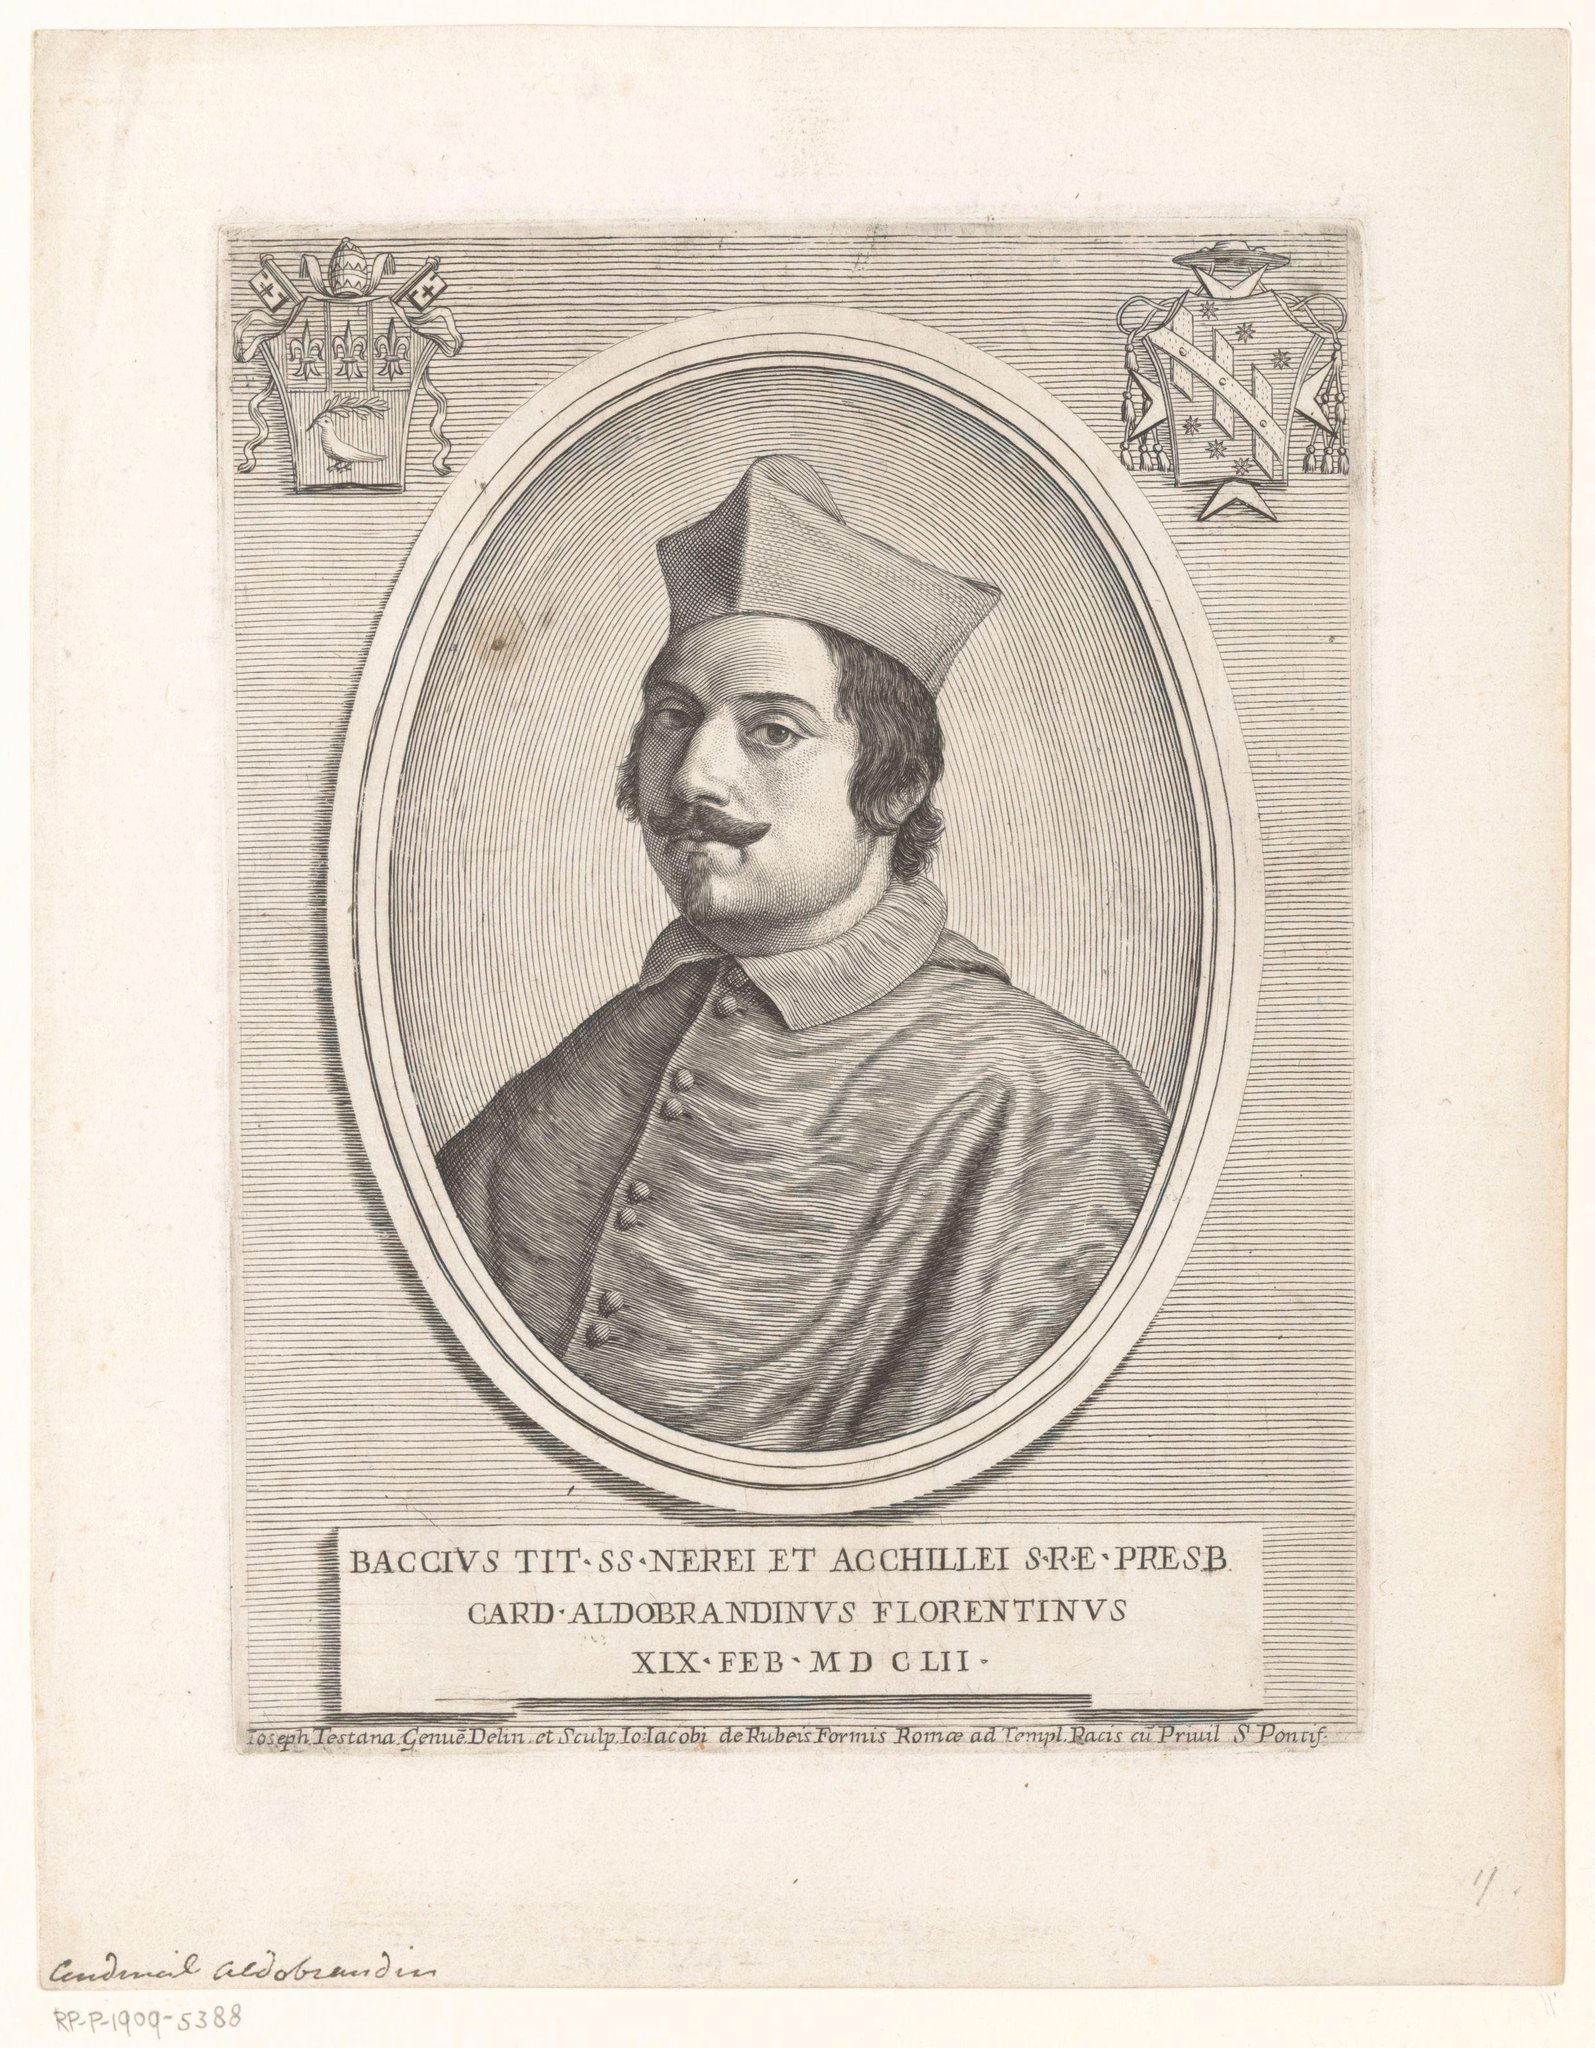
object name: print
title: Portretten van kardinalen met twee wapenschilden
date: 1658-1679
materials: paper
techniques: engraving, intaglio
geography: rome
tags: cardinal, historical persons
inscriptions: collector's mark: Lugt 2228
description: Prent uit een reeks van onbekende omvang met portretten van kardinalen. De prenten werden vanaf 1657 vervaardigd in opdracht van uitgever Giovanni Giacomo de’ Rossi, waarna de productie werd voortgezet onder leiding van zijn opvolgers Domenico de’ Rossi en Lorenzo Filippo de’ Rossi, en ten slotte onder leiding van de Calcographia R.C.A.